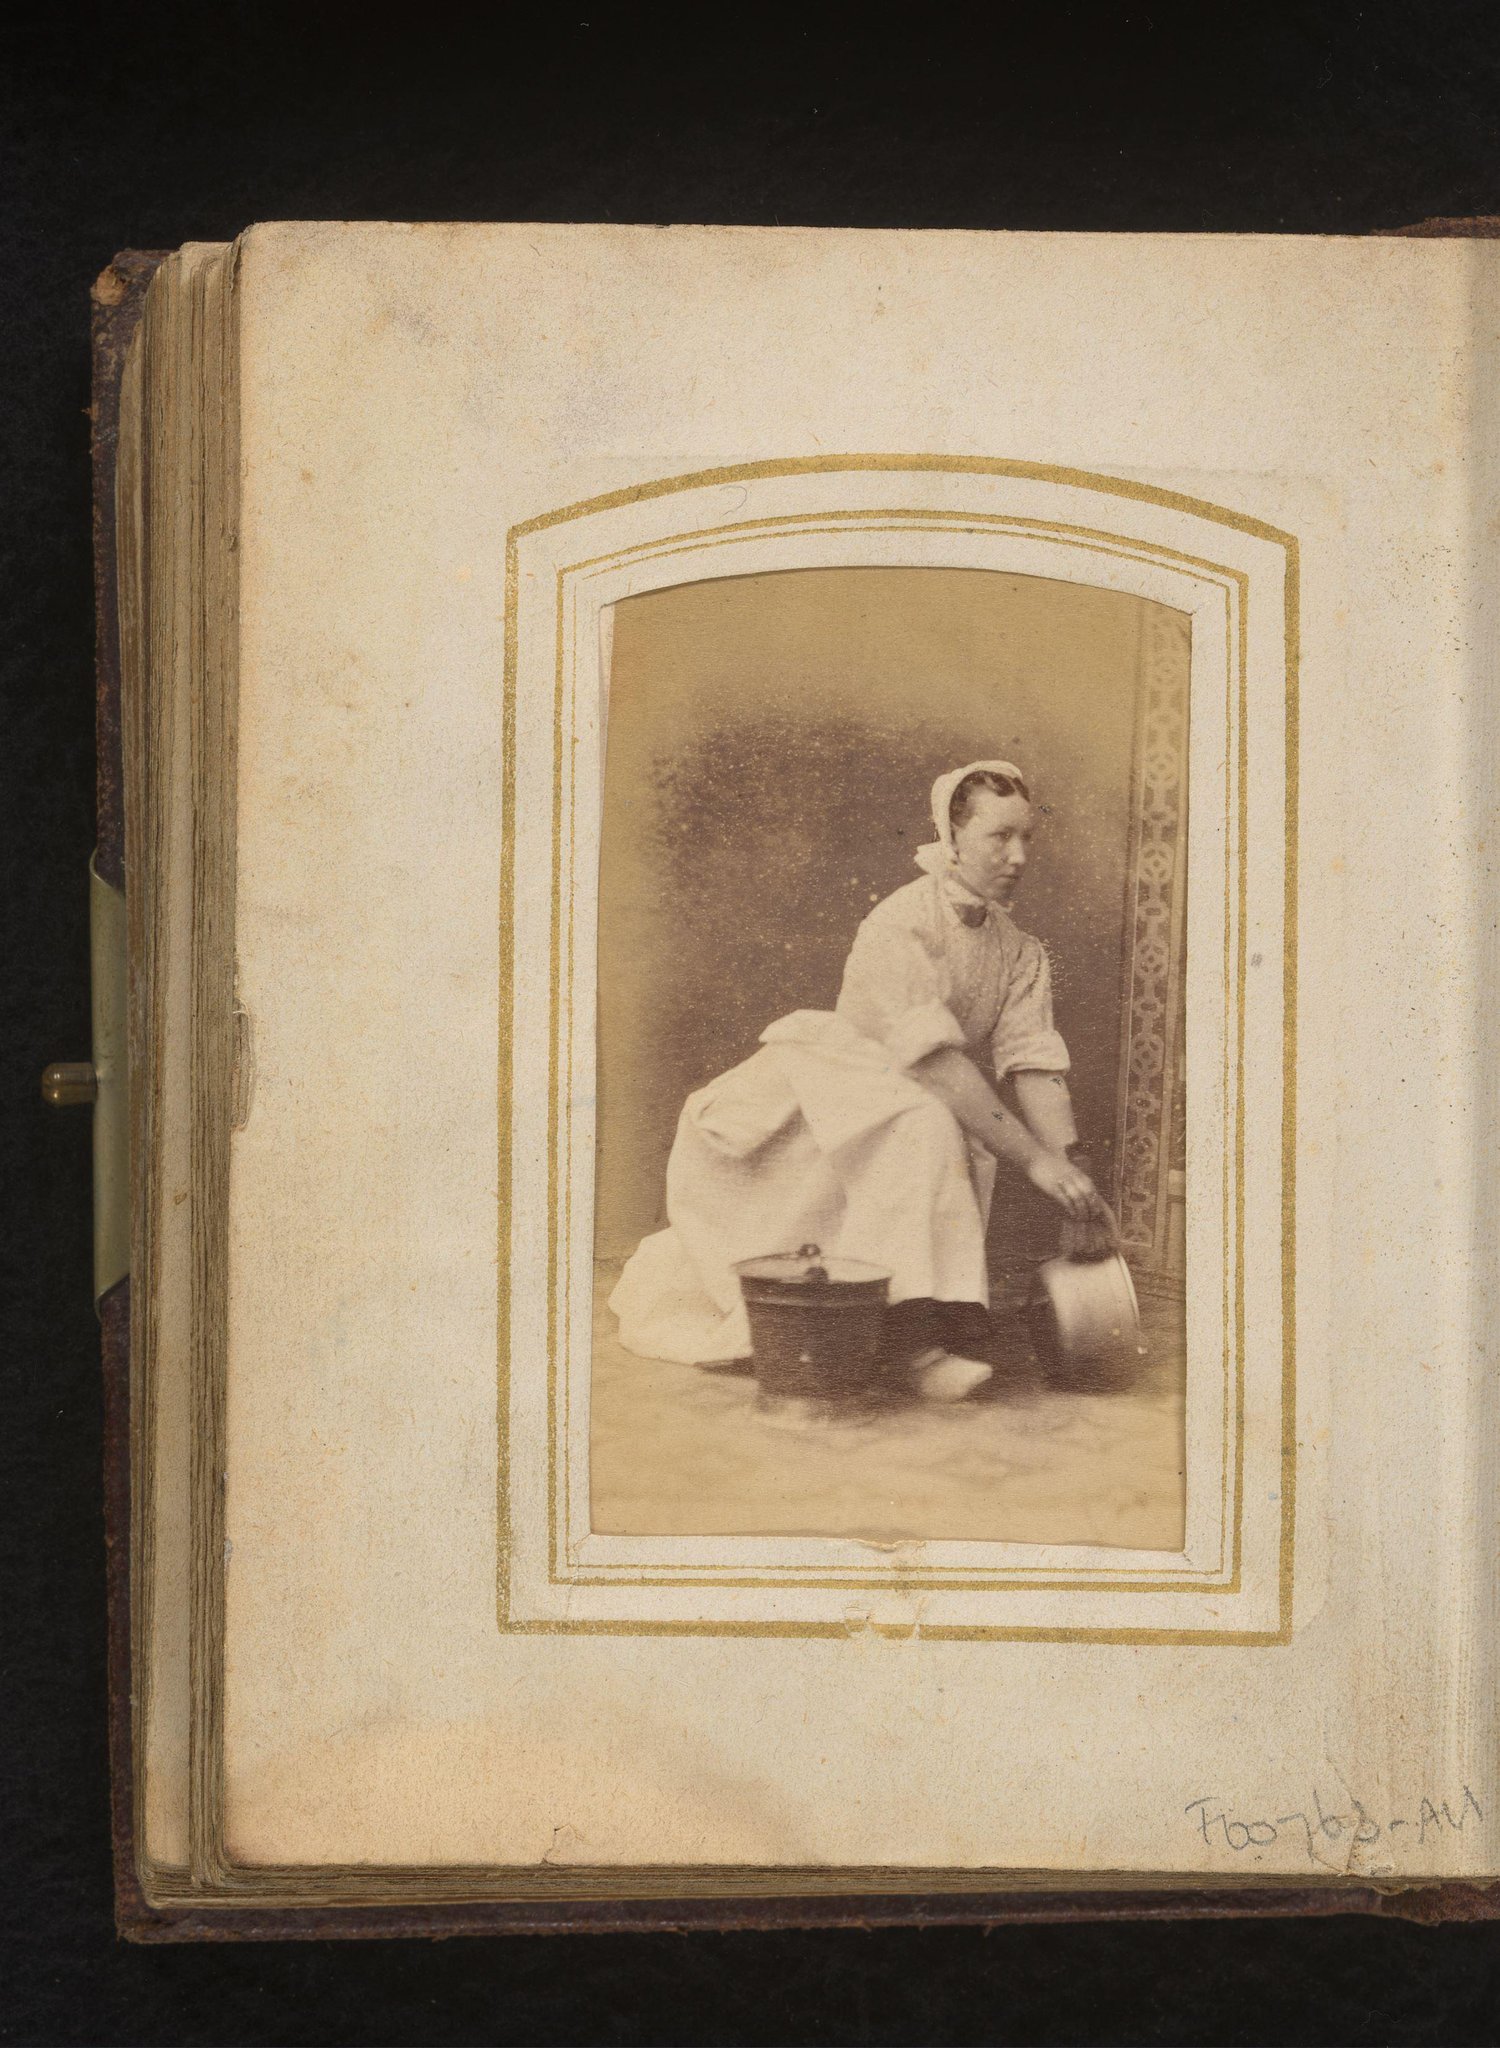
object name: carte de visite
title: Portret van een dienstbode met klompen en muts, hurkend bij emmers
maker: simon van caspel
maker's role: fotograaf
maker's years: 1843-1880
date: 1867-1880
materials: cardboard, photographic support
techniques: albumen print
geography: amsterdam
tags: historical persons - bb - woman, wooden shoes, clogs, head-gear: cap, maid ~ house personnel, container of metal: bucket, can, canister, drum, tin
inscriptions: inscription: ‘PHOTOGRAPHISCH ETABLISSEMENT/ van/ S. van CASPEL/ Wolvenstraat K K. 19./ AMSTERDAM’